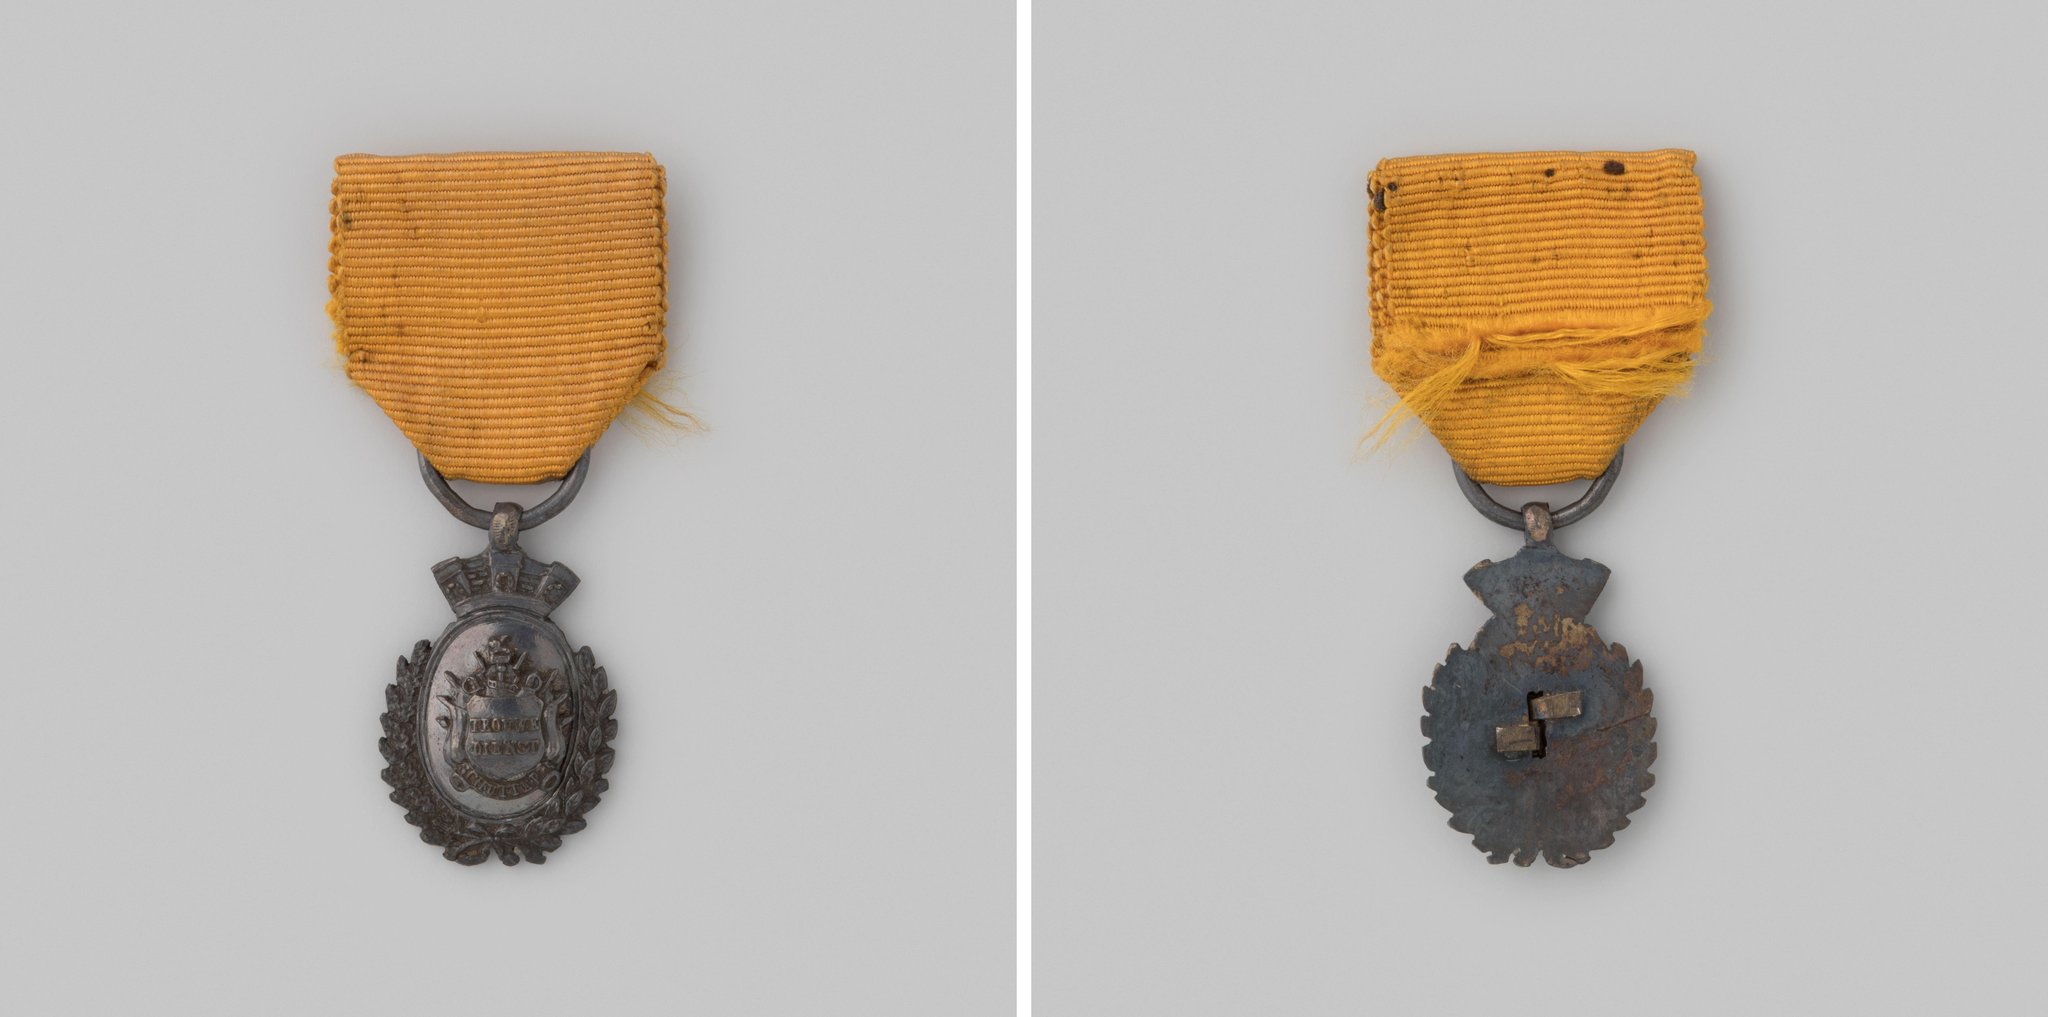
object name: honorary medal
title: Ereteken voor eervolle, langdurige en werkelijke dienst bij de schutterij voor onderofficieren en minderen, gedragen door Mr. W.K. van der Breggen, lid van de schuttersraad te Amsterdam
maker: Anonymous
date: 1851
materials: silver, textile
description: Zilveren draagpenning met knop, ring en lint.